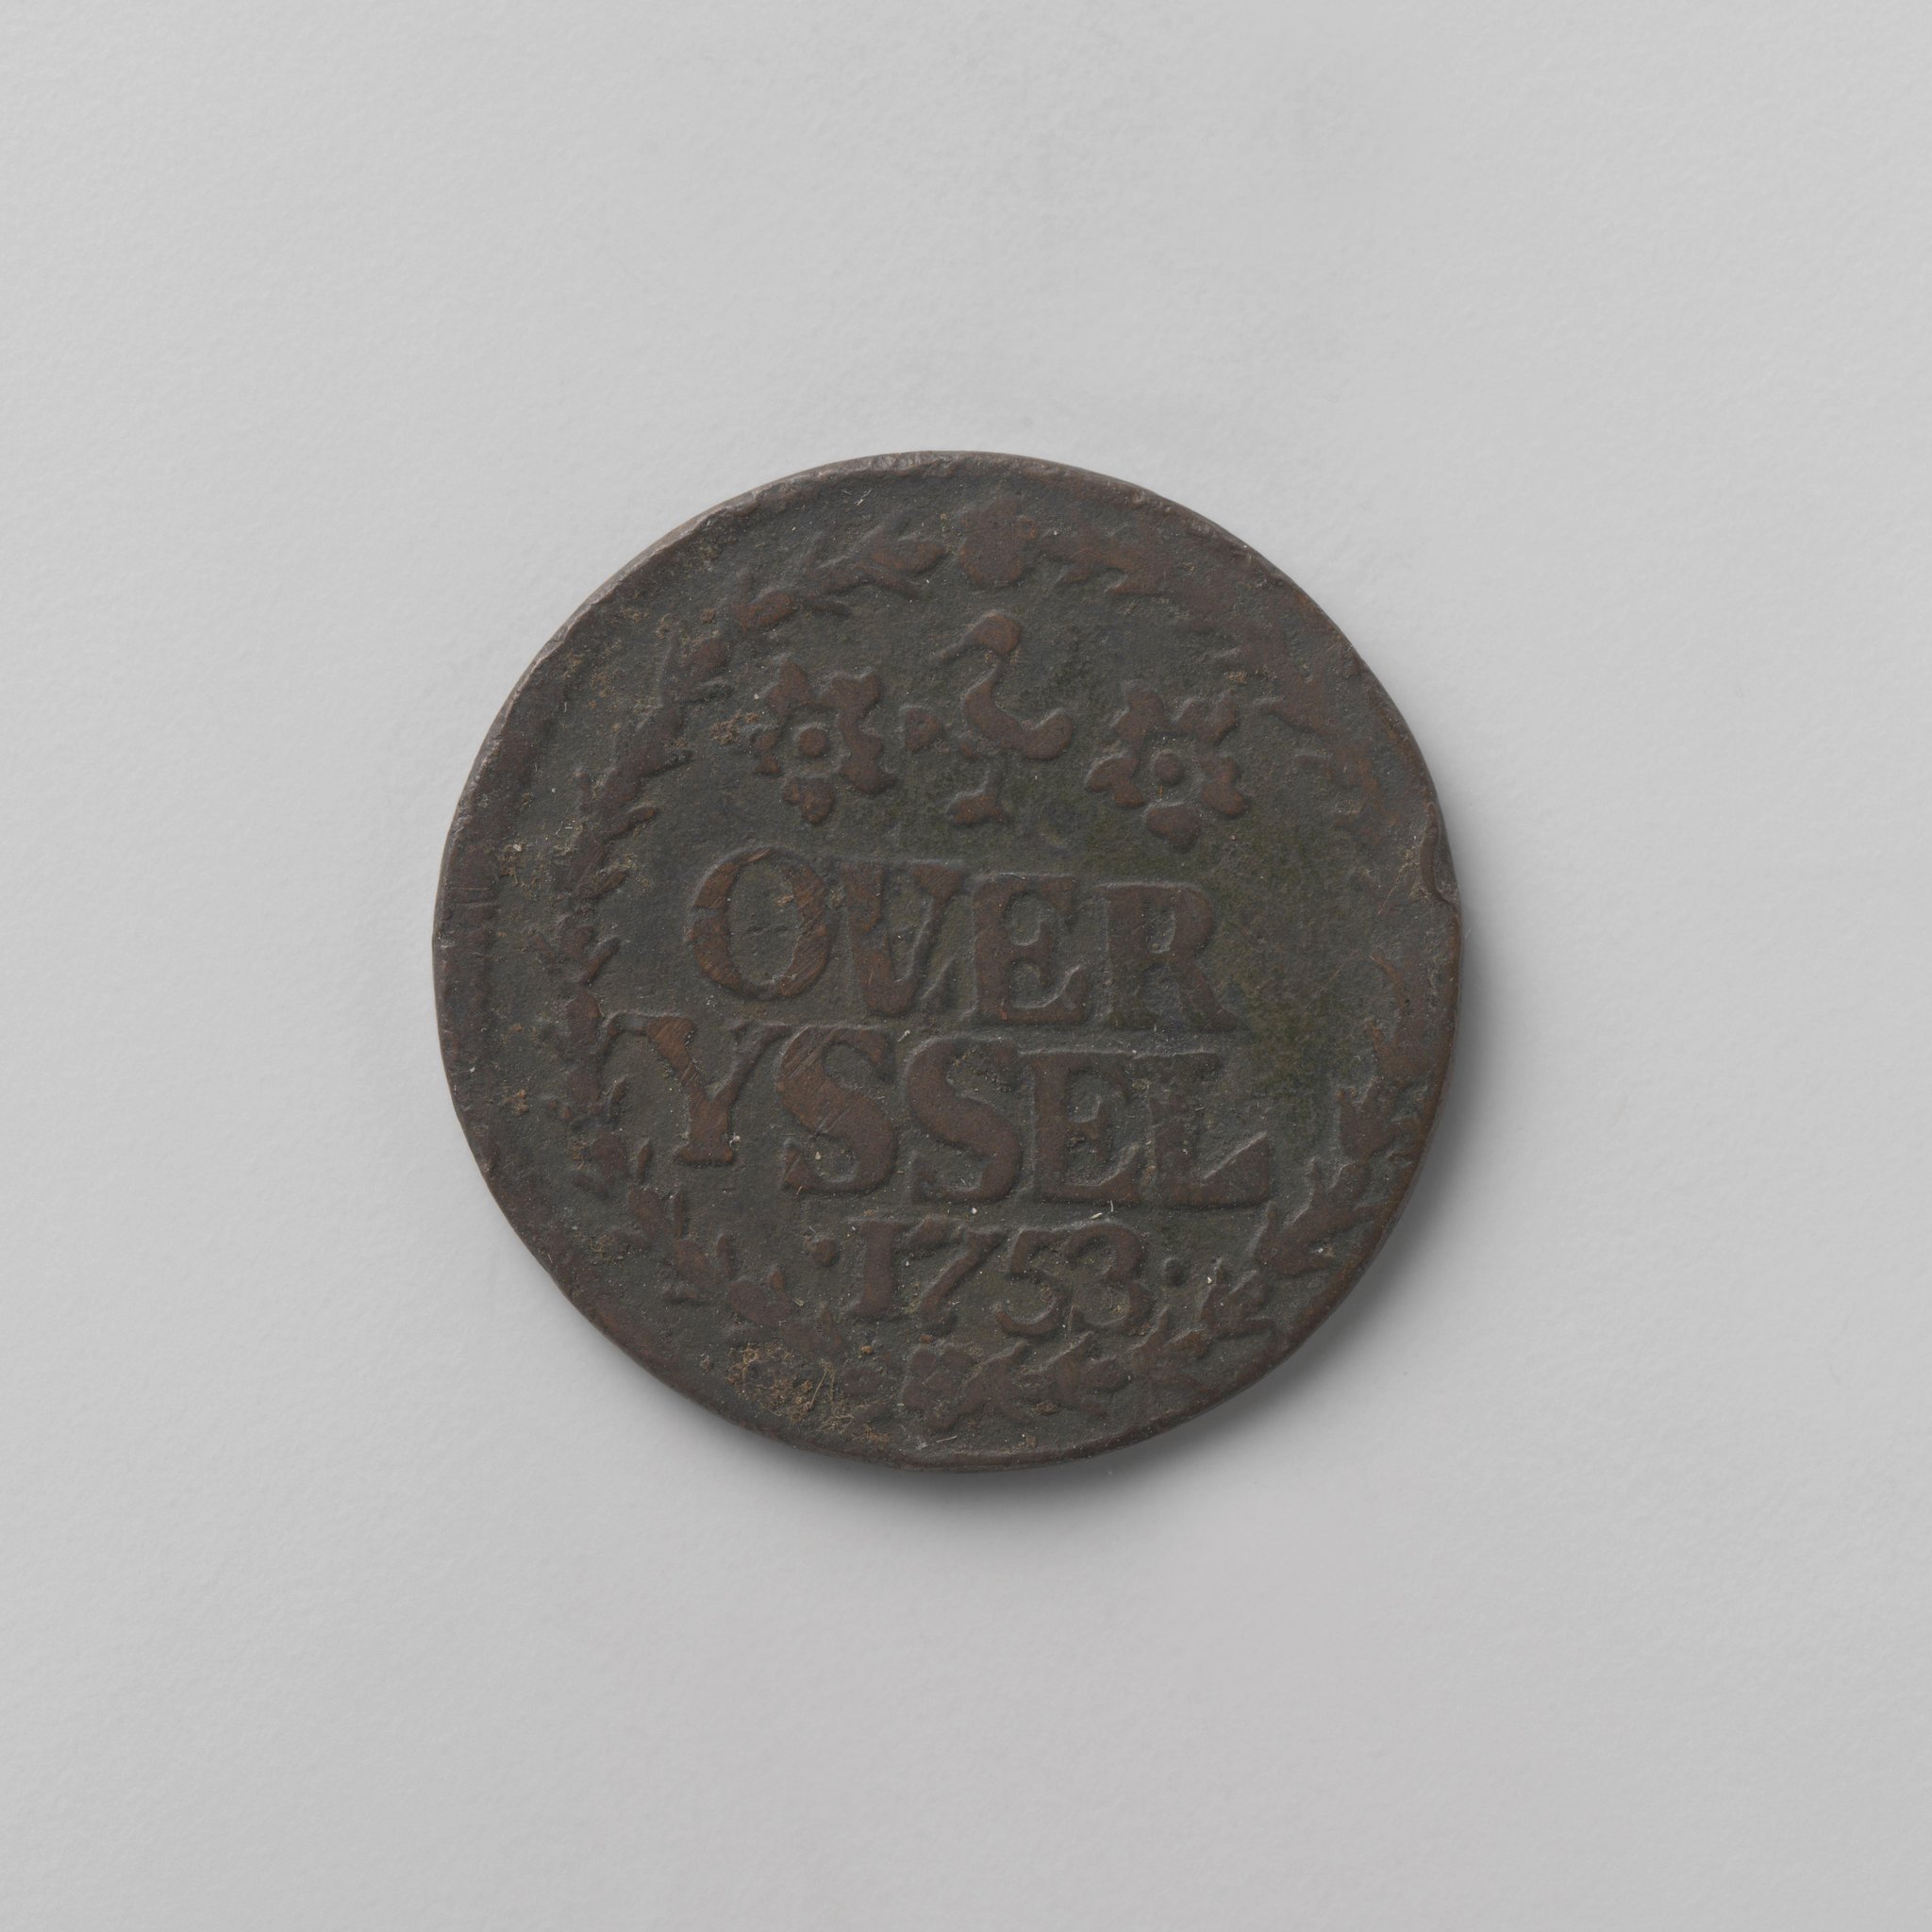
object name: coin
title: Overijssel, duit, 1753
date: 1753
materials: copper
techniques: striking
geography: kampen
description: Koperen munt. Voorzijde: tussen wapenspreuk gekroond provinciaal wapenschild. Keerzijde: binnen lauwerkrans tweeregelig opschrift, waarboven muntmeesterteken en waaronder jaartal.